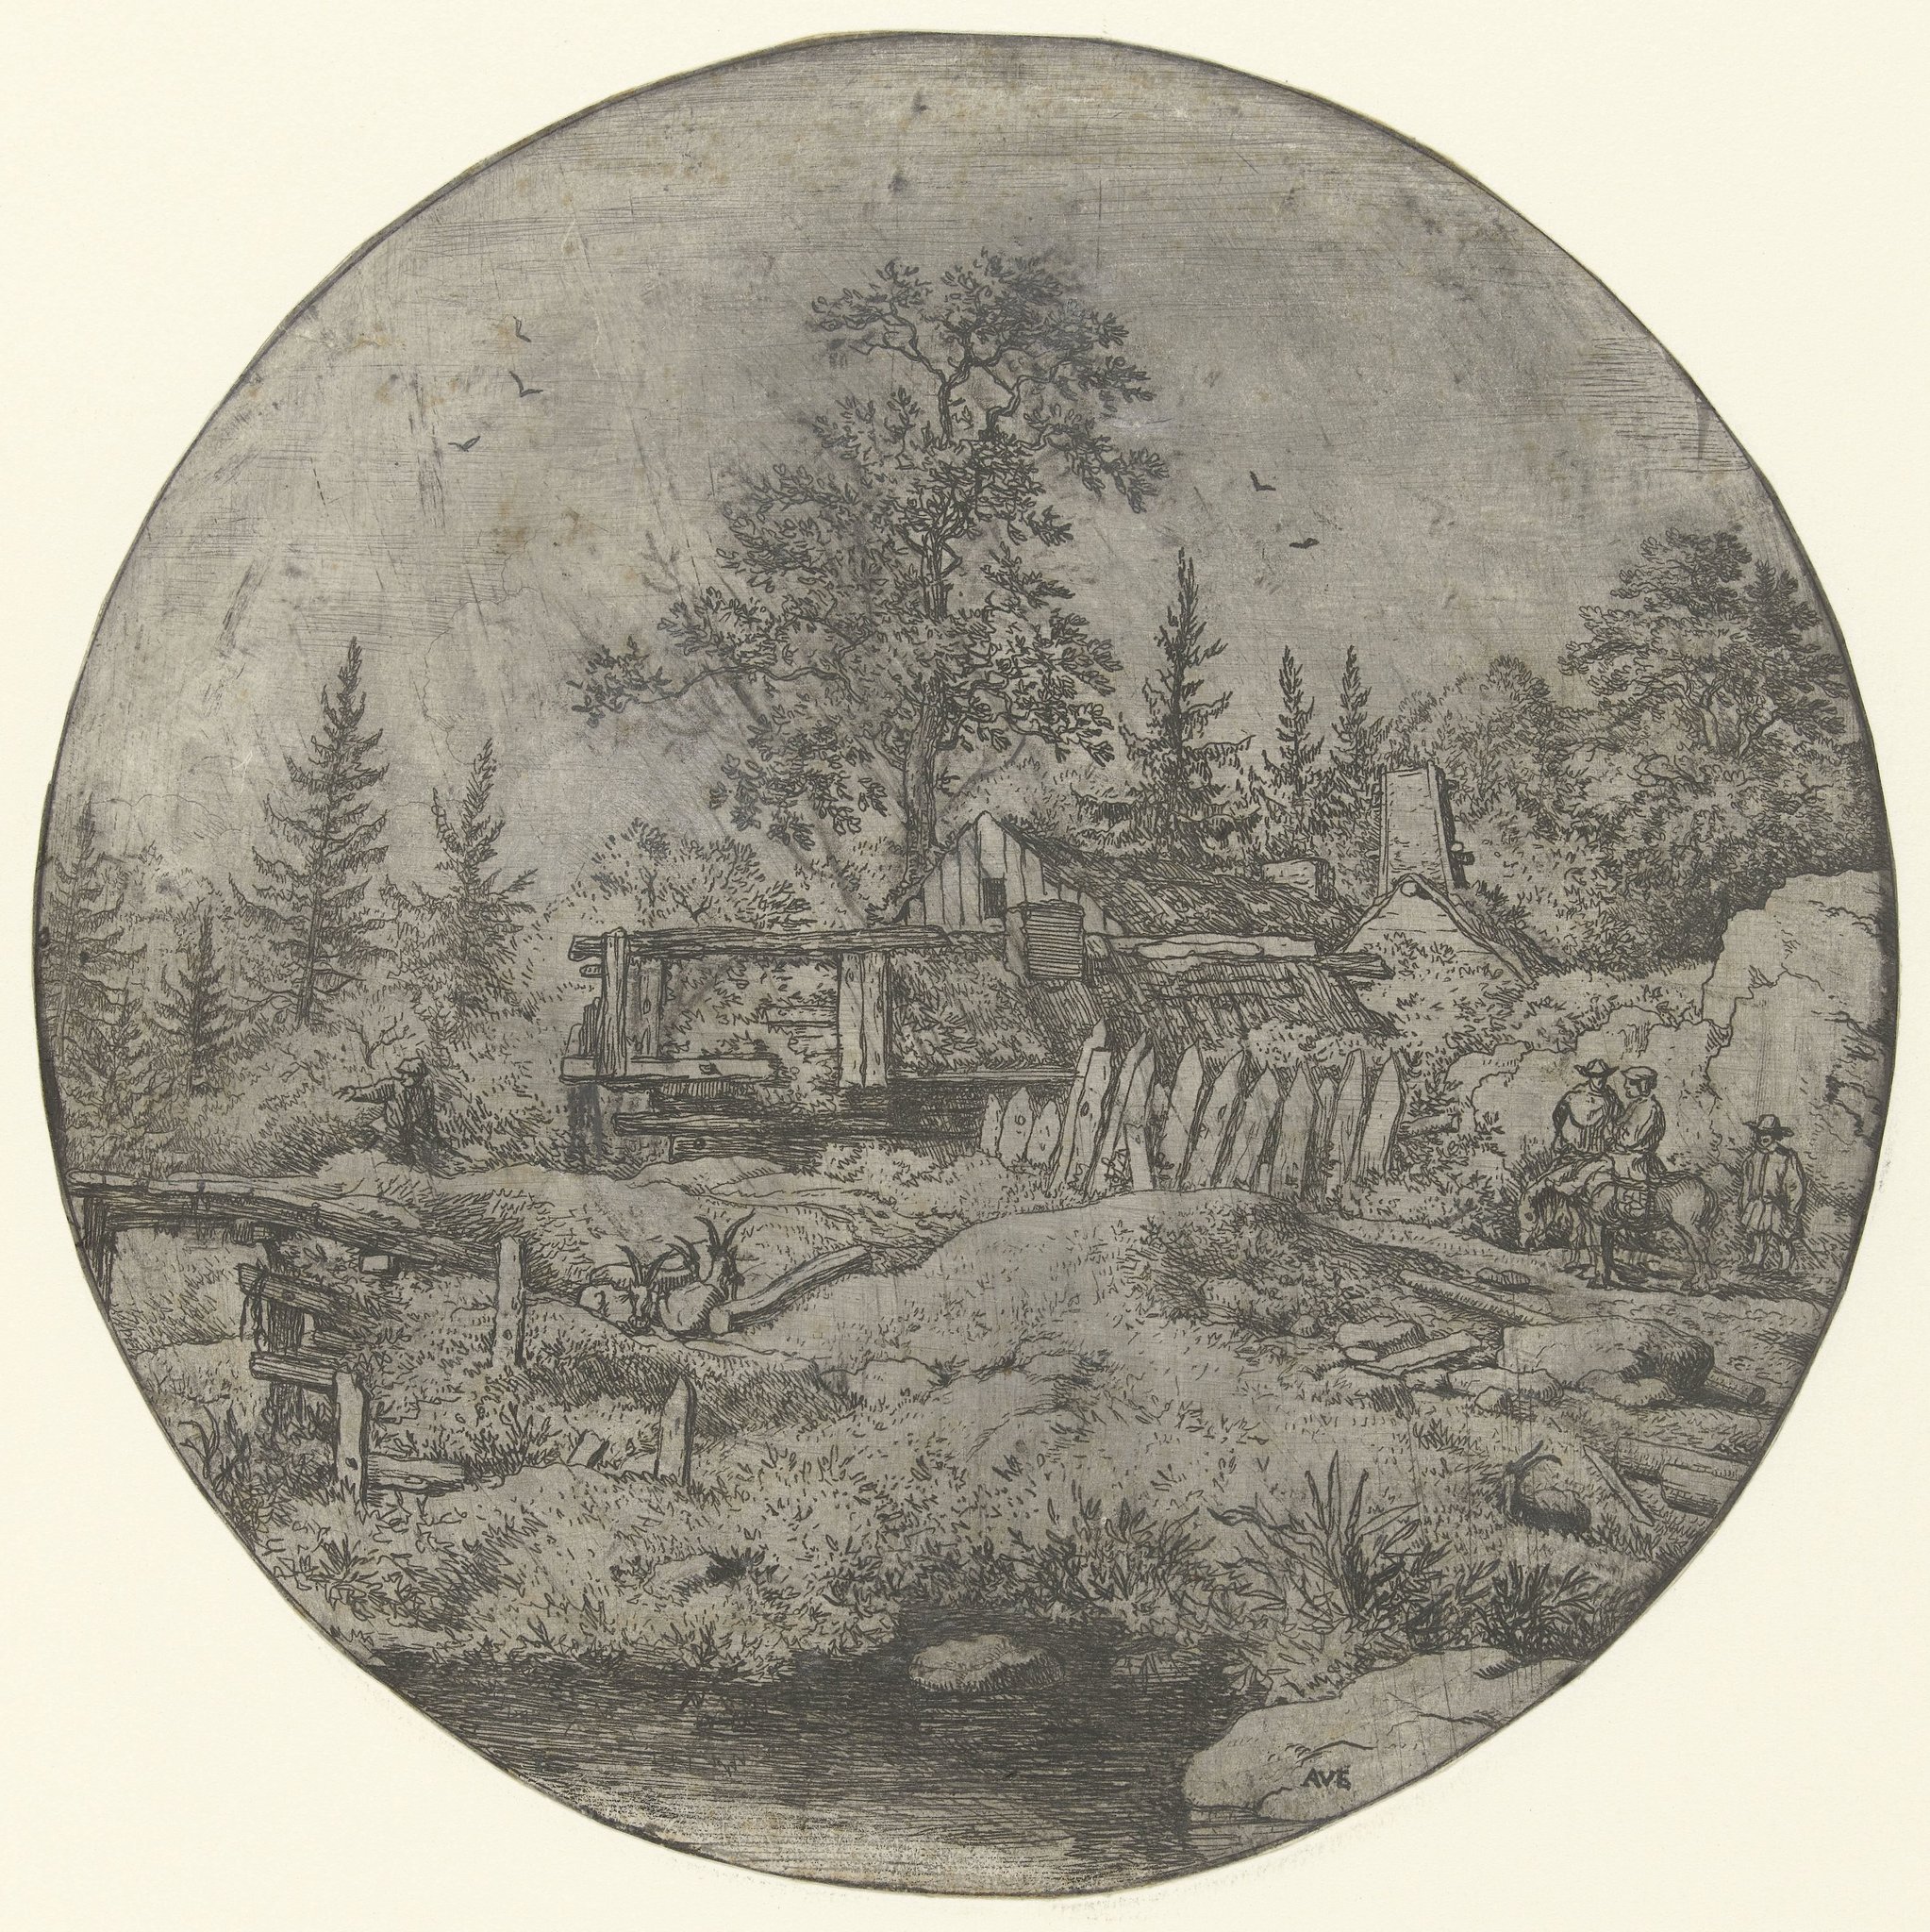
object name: print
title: Landschap met houten brug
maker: allaert van everdingen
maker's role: draughtsman, painter, print maker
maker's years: 1621-1675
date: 1631-1675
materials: paper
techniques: etching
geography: netherlands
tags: landscapes (+ landscape with figures, staffage)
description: Rond landschap met een gehucht van houten gebouwen en een pad waarop een man te paard en twee voetgangers. Verderop bij een brug een vierde man.